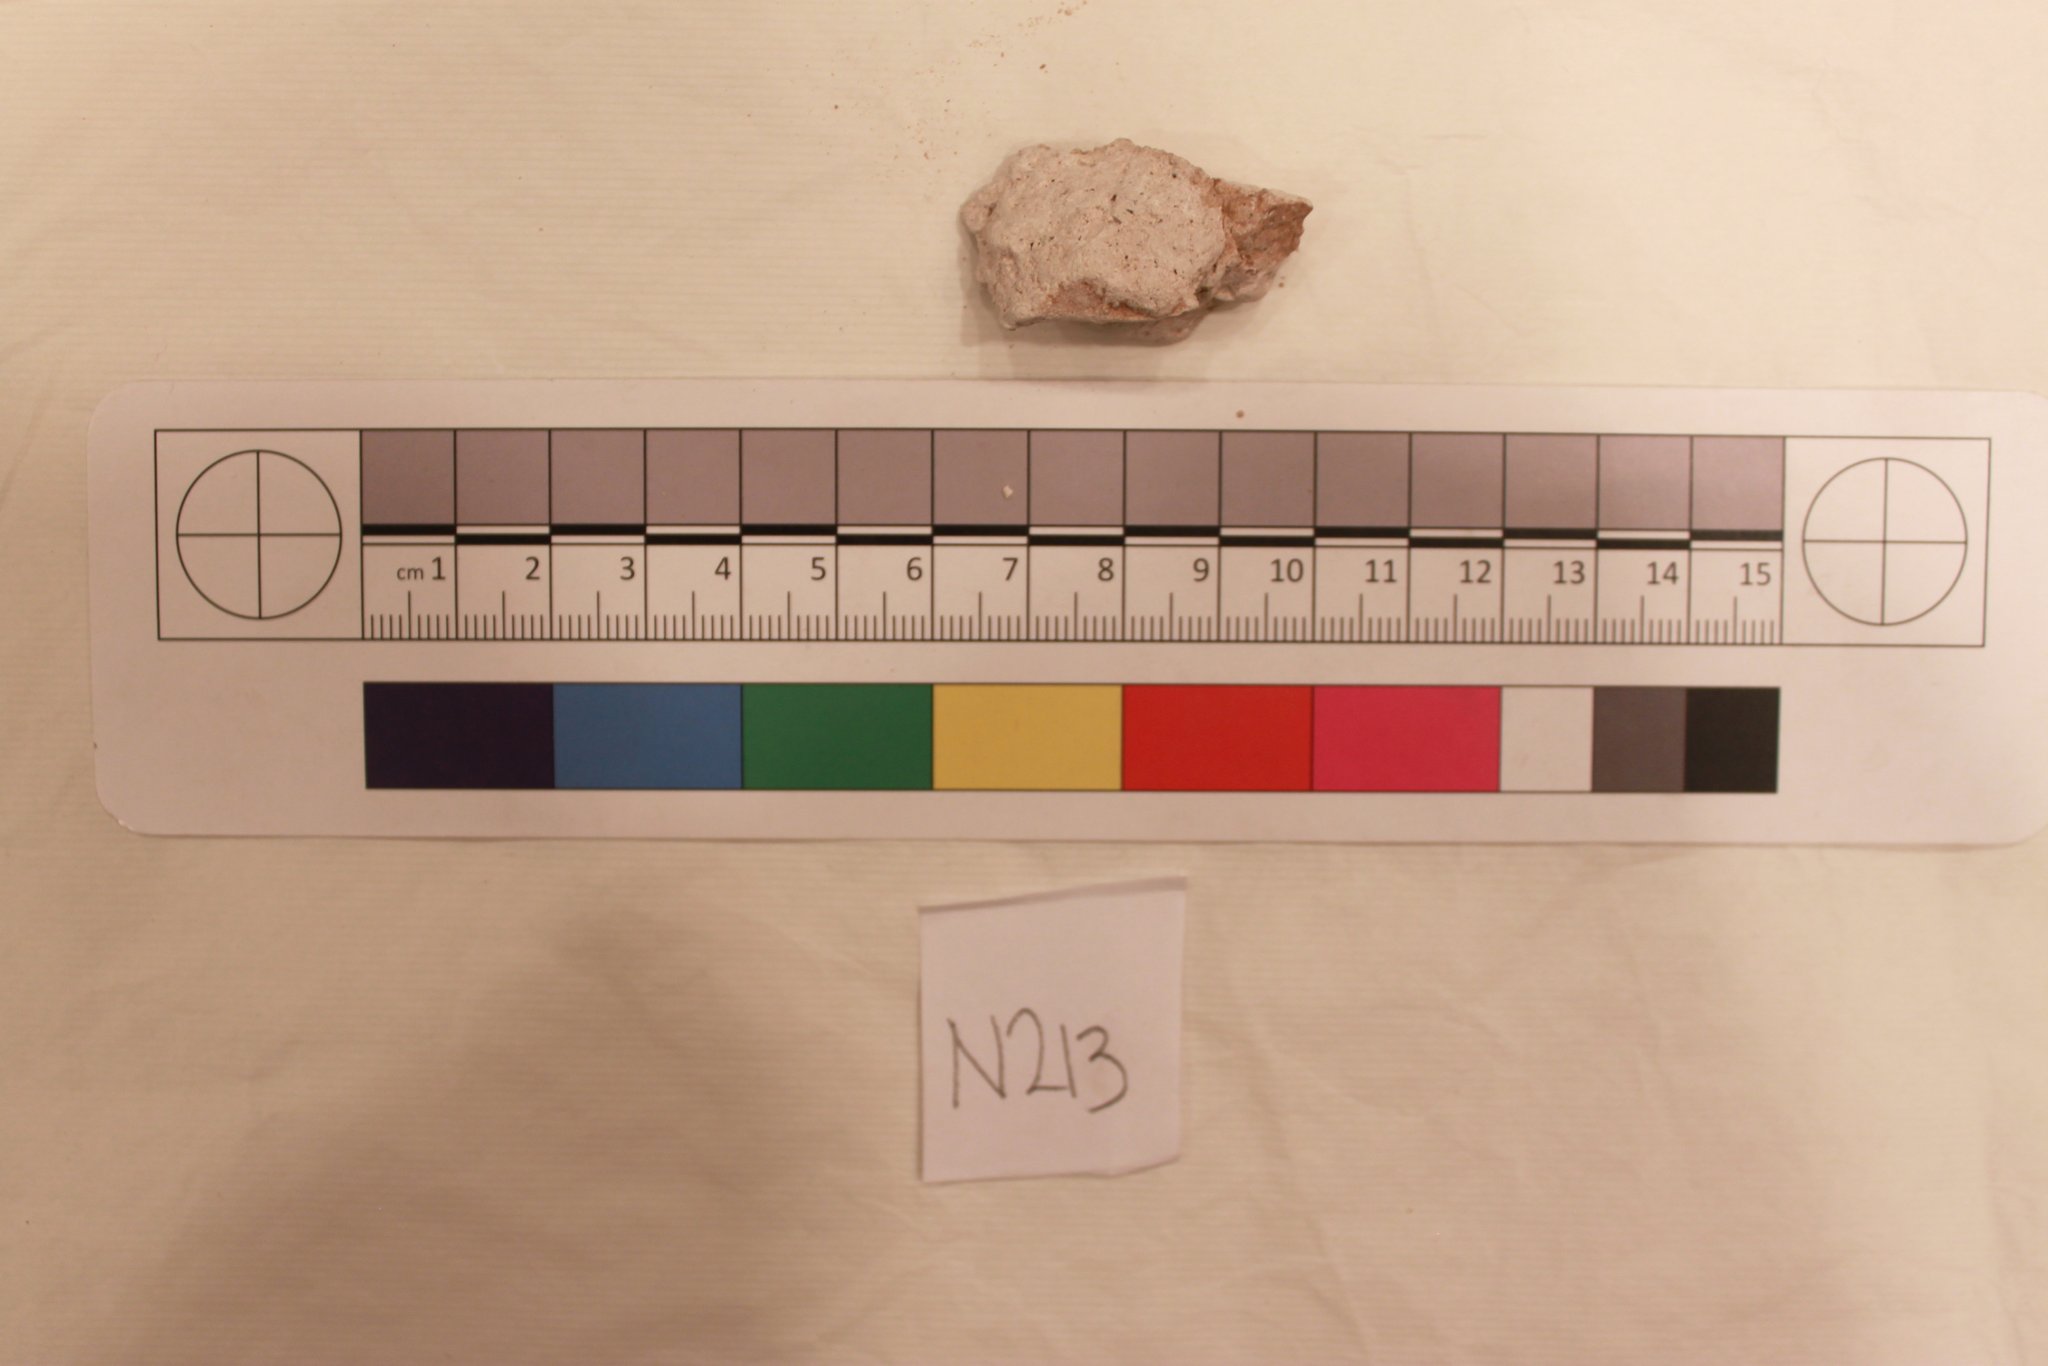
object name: fragment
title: Stucco Fragment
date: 701-1200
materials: plaster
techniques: carving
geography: iran